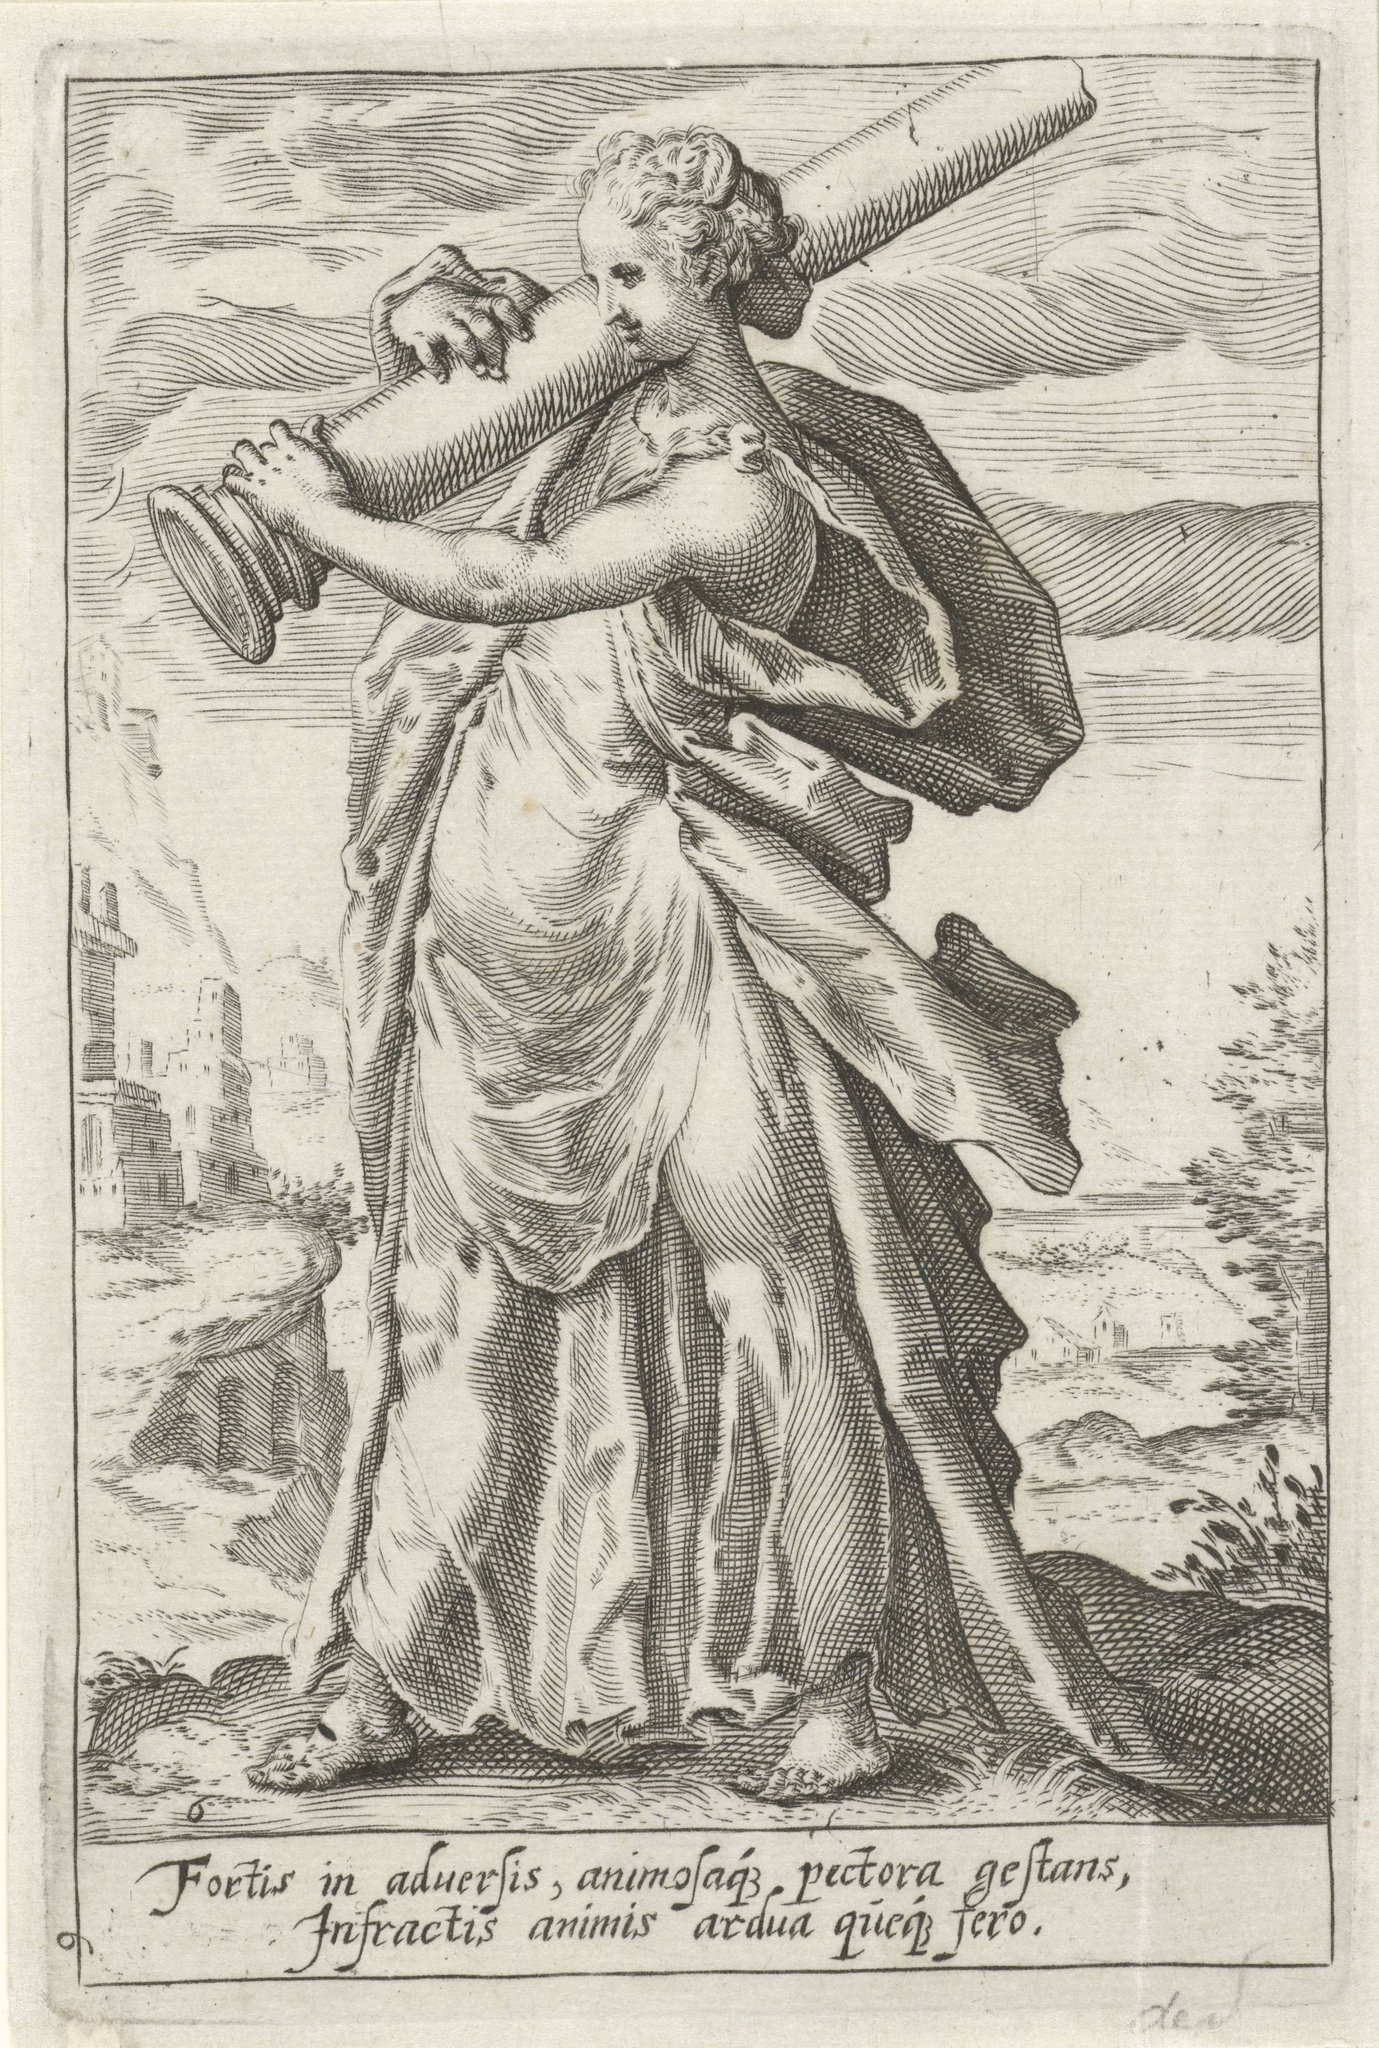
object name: print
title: Kracht (Fortitudo)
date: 1601-1652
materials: paper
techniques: engraving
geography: amsterdam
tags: fortitude, 'fortitudo' ~ one of the four cardinal virtues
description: De gepersonifieerde Kracht; een vrouwenfiguur met een zuil over haar rechter schouder. Op de achtergrond een heuvellandschap.